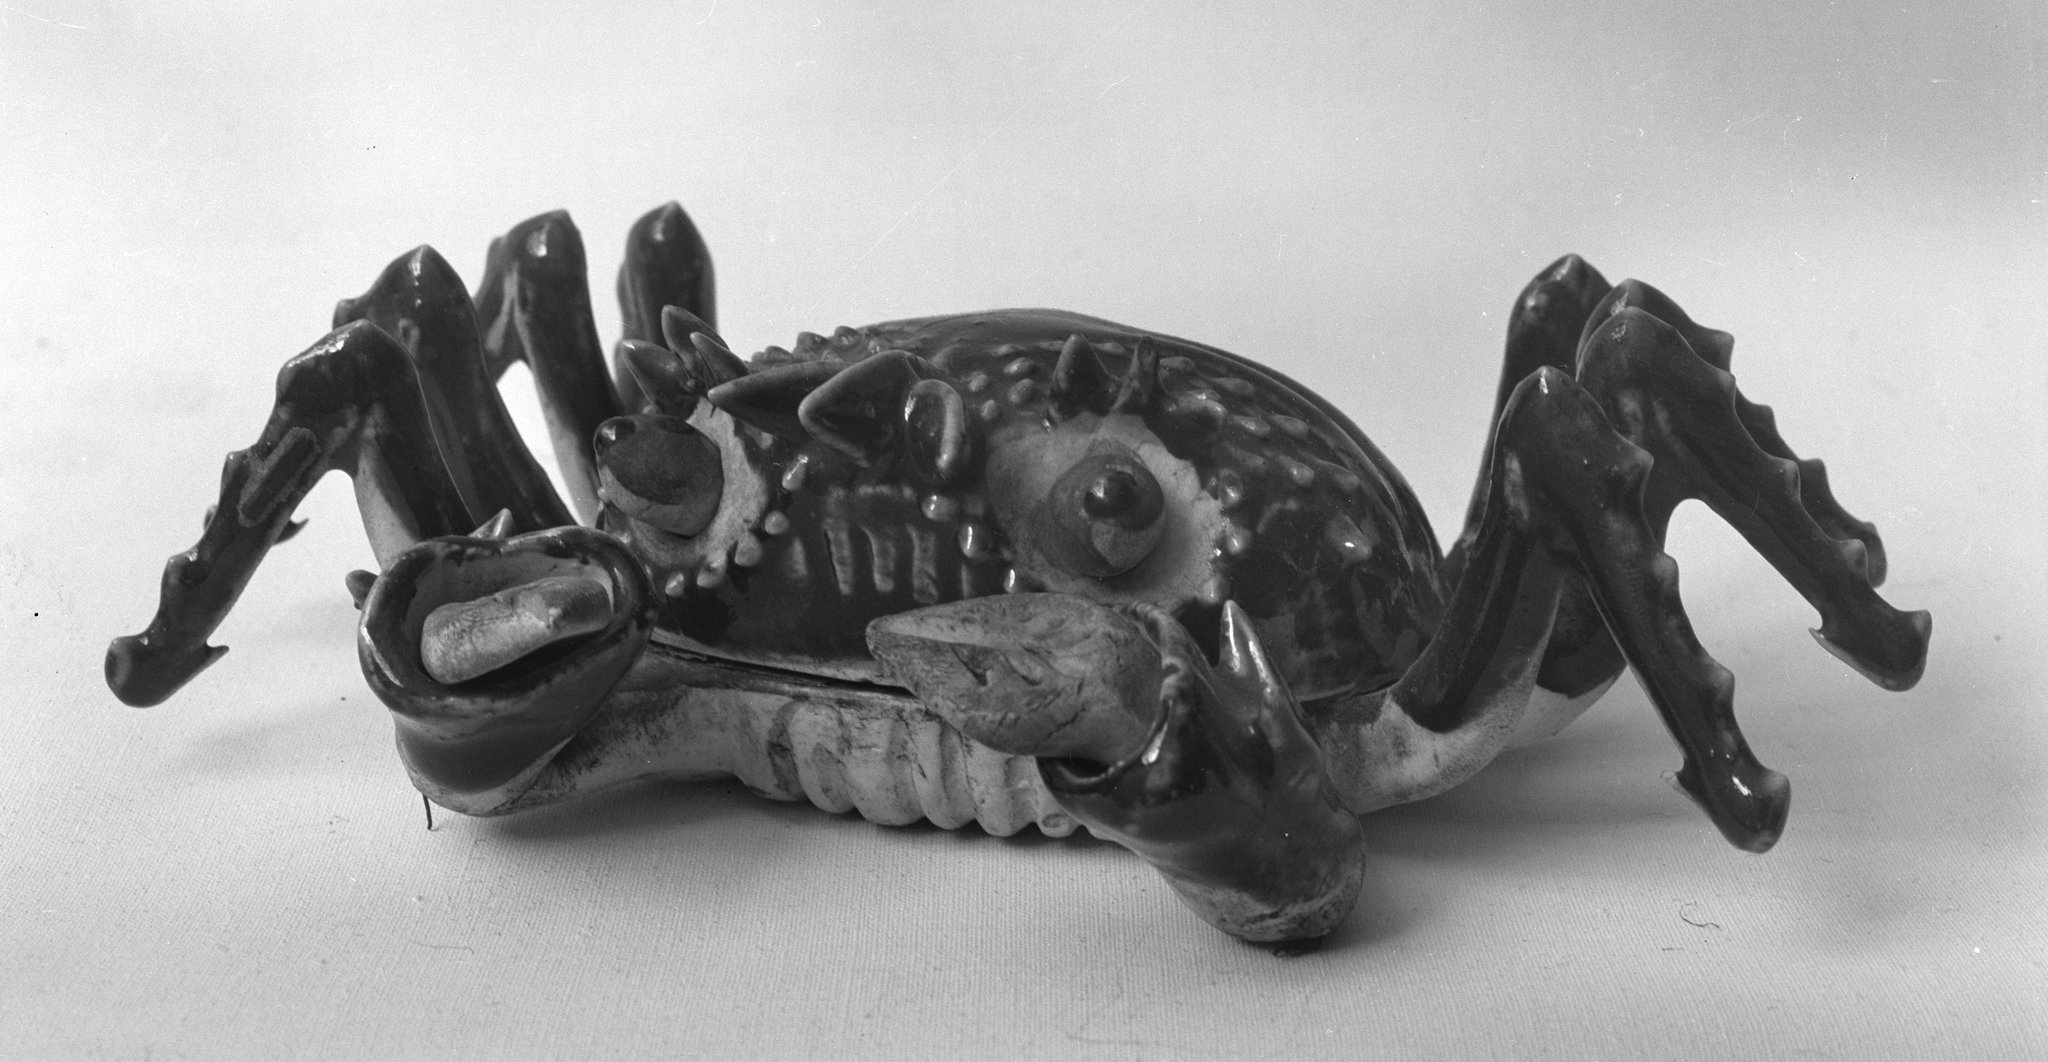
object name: covered box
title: Covered box in the shape of a crab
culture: chinese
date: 1801-1850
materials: glaze, porcelain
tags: crabs